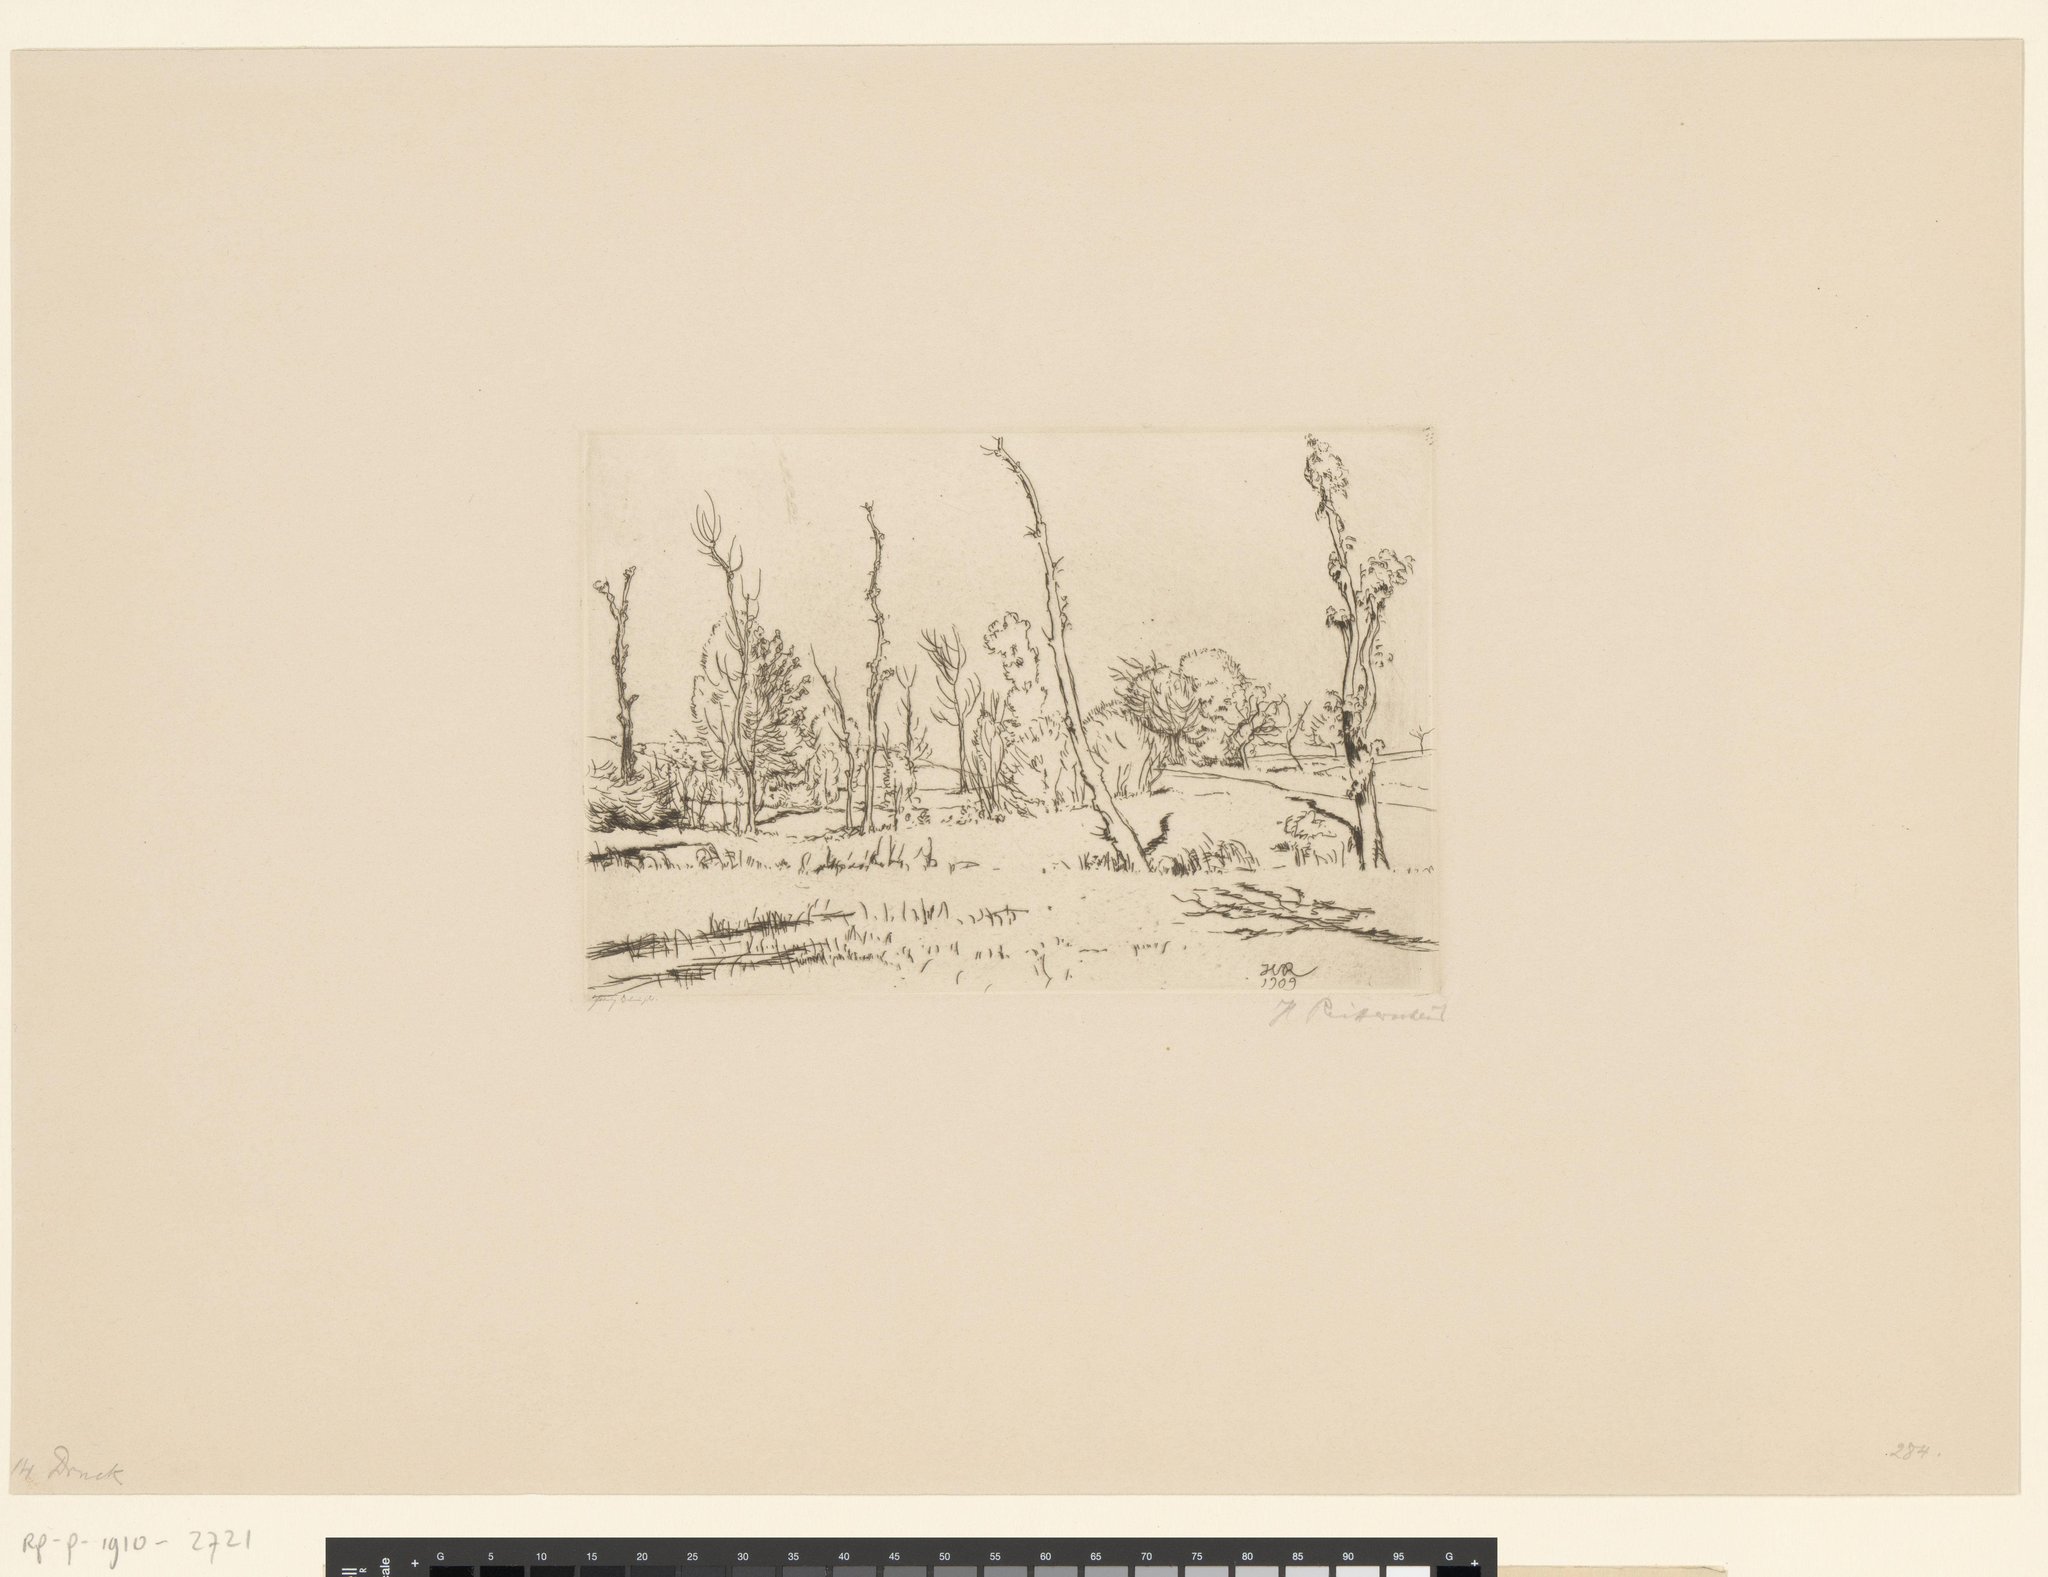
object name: print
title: Winterlandschap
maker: heinrich reifferscheid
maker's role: print maker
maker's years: 1872-1945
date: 1909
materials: paper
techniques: etching, intaglio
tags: winter landscape; landscape symbolizing winter (the four seasons of the year)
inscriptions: signature, collector's mark: Lugt 2228